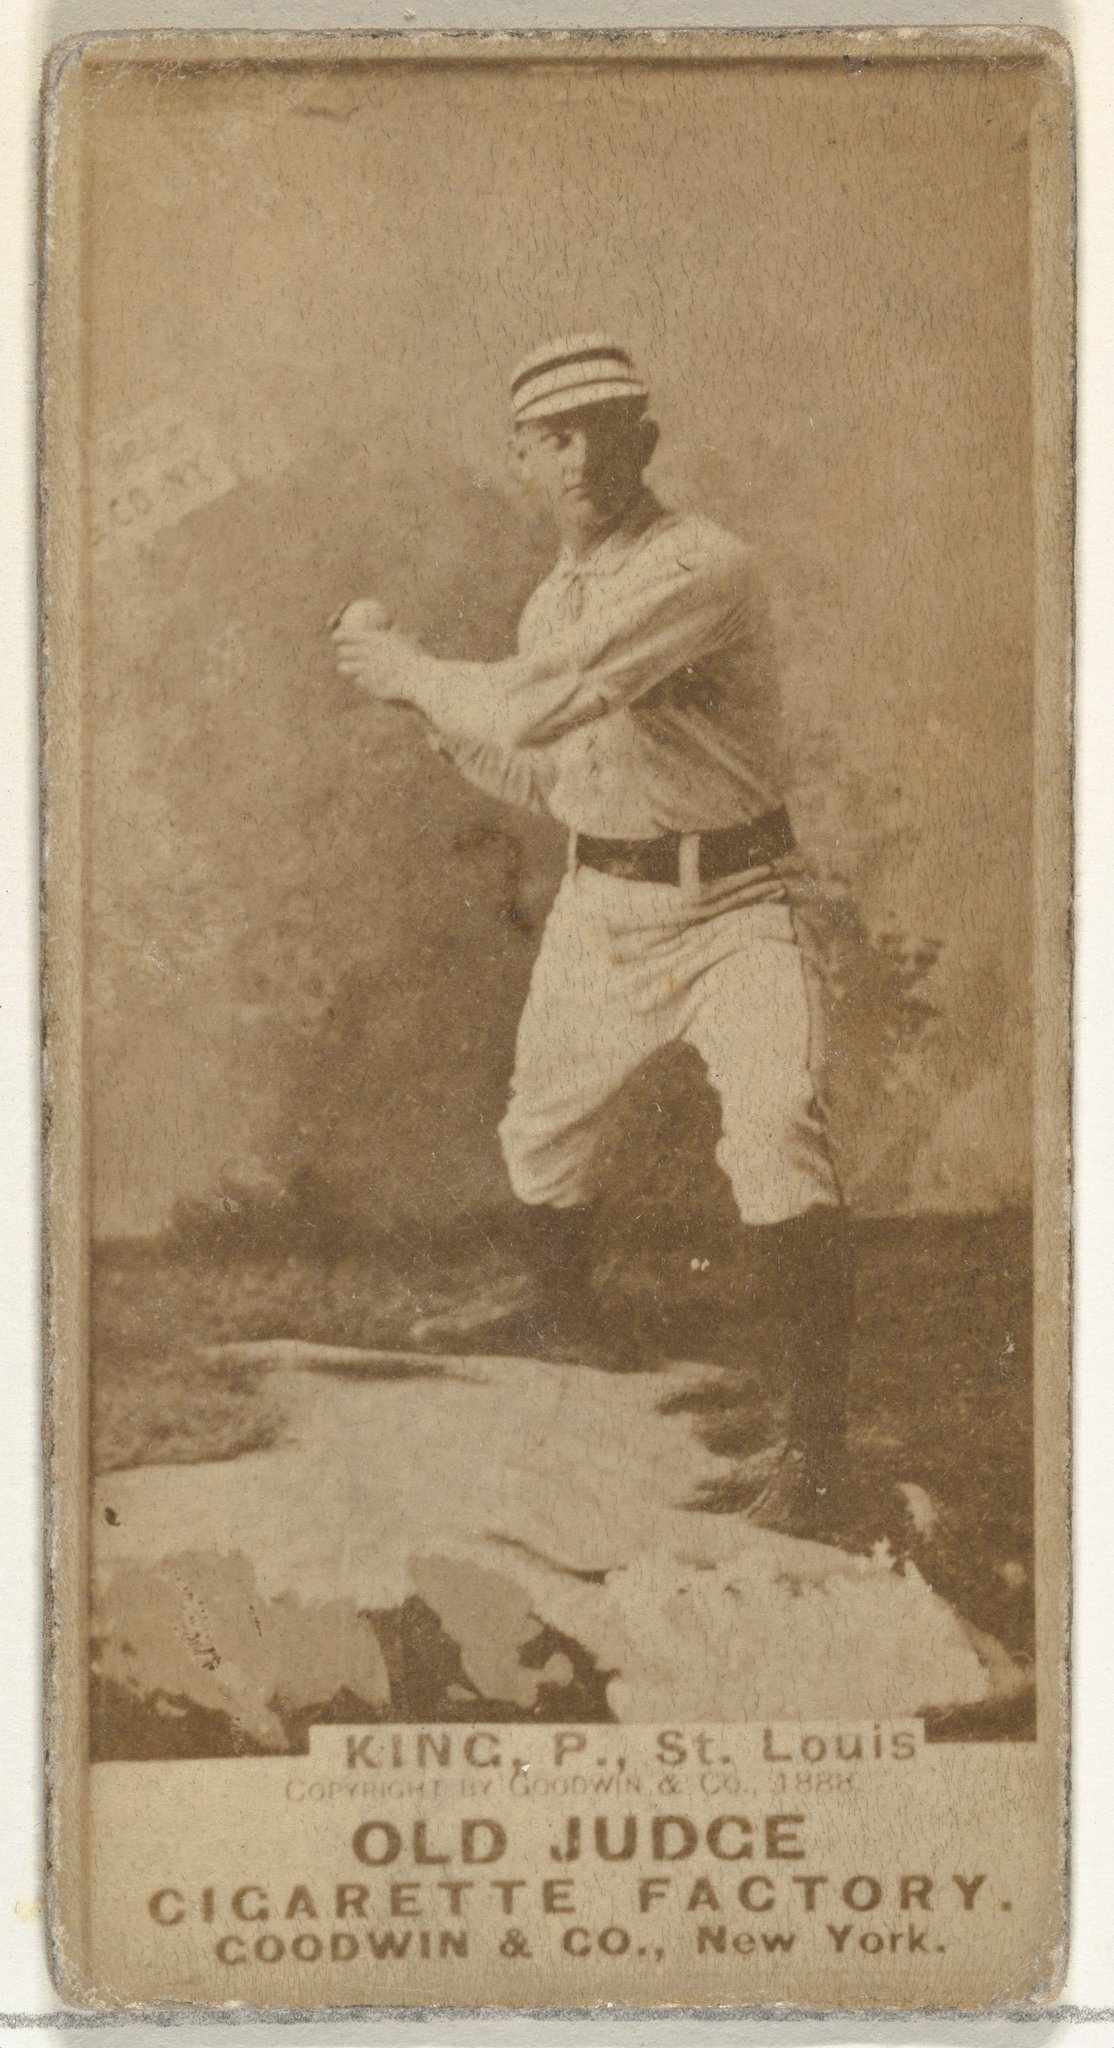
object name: baseball card, photograph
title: Charles Frederick "Silver" King, Pitcher, St. Louis Browns, from the Old Judge series (N172) for Old Judge Cigarettes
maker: goodwin & company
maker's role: publisher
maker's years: 1850-1950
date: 1888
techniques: albumen silver print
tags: men,portraits,baseball,athletes